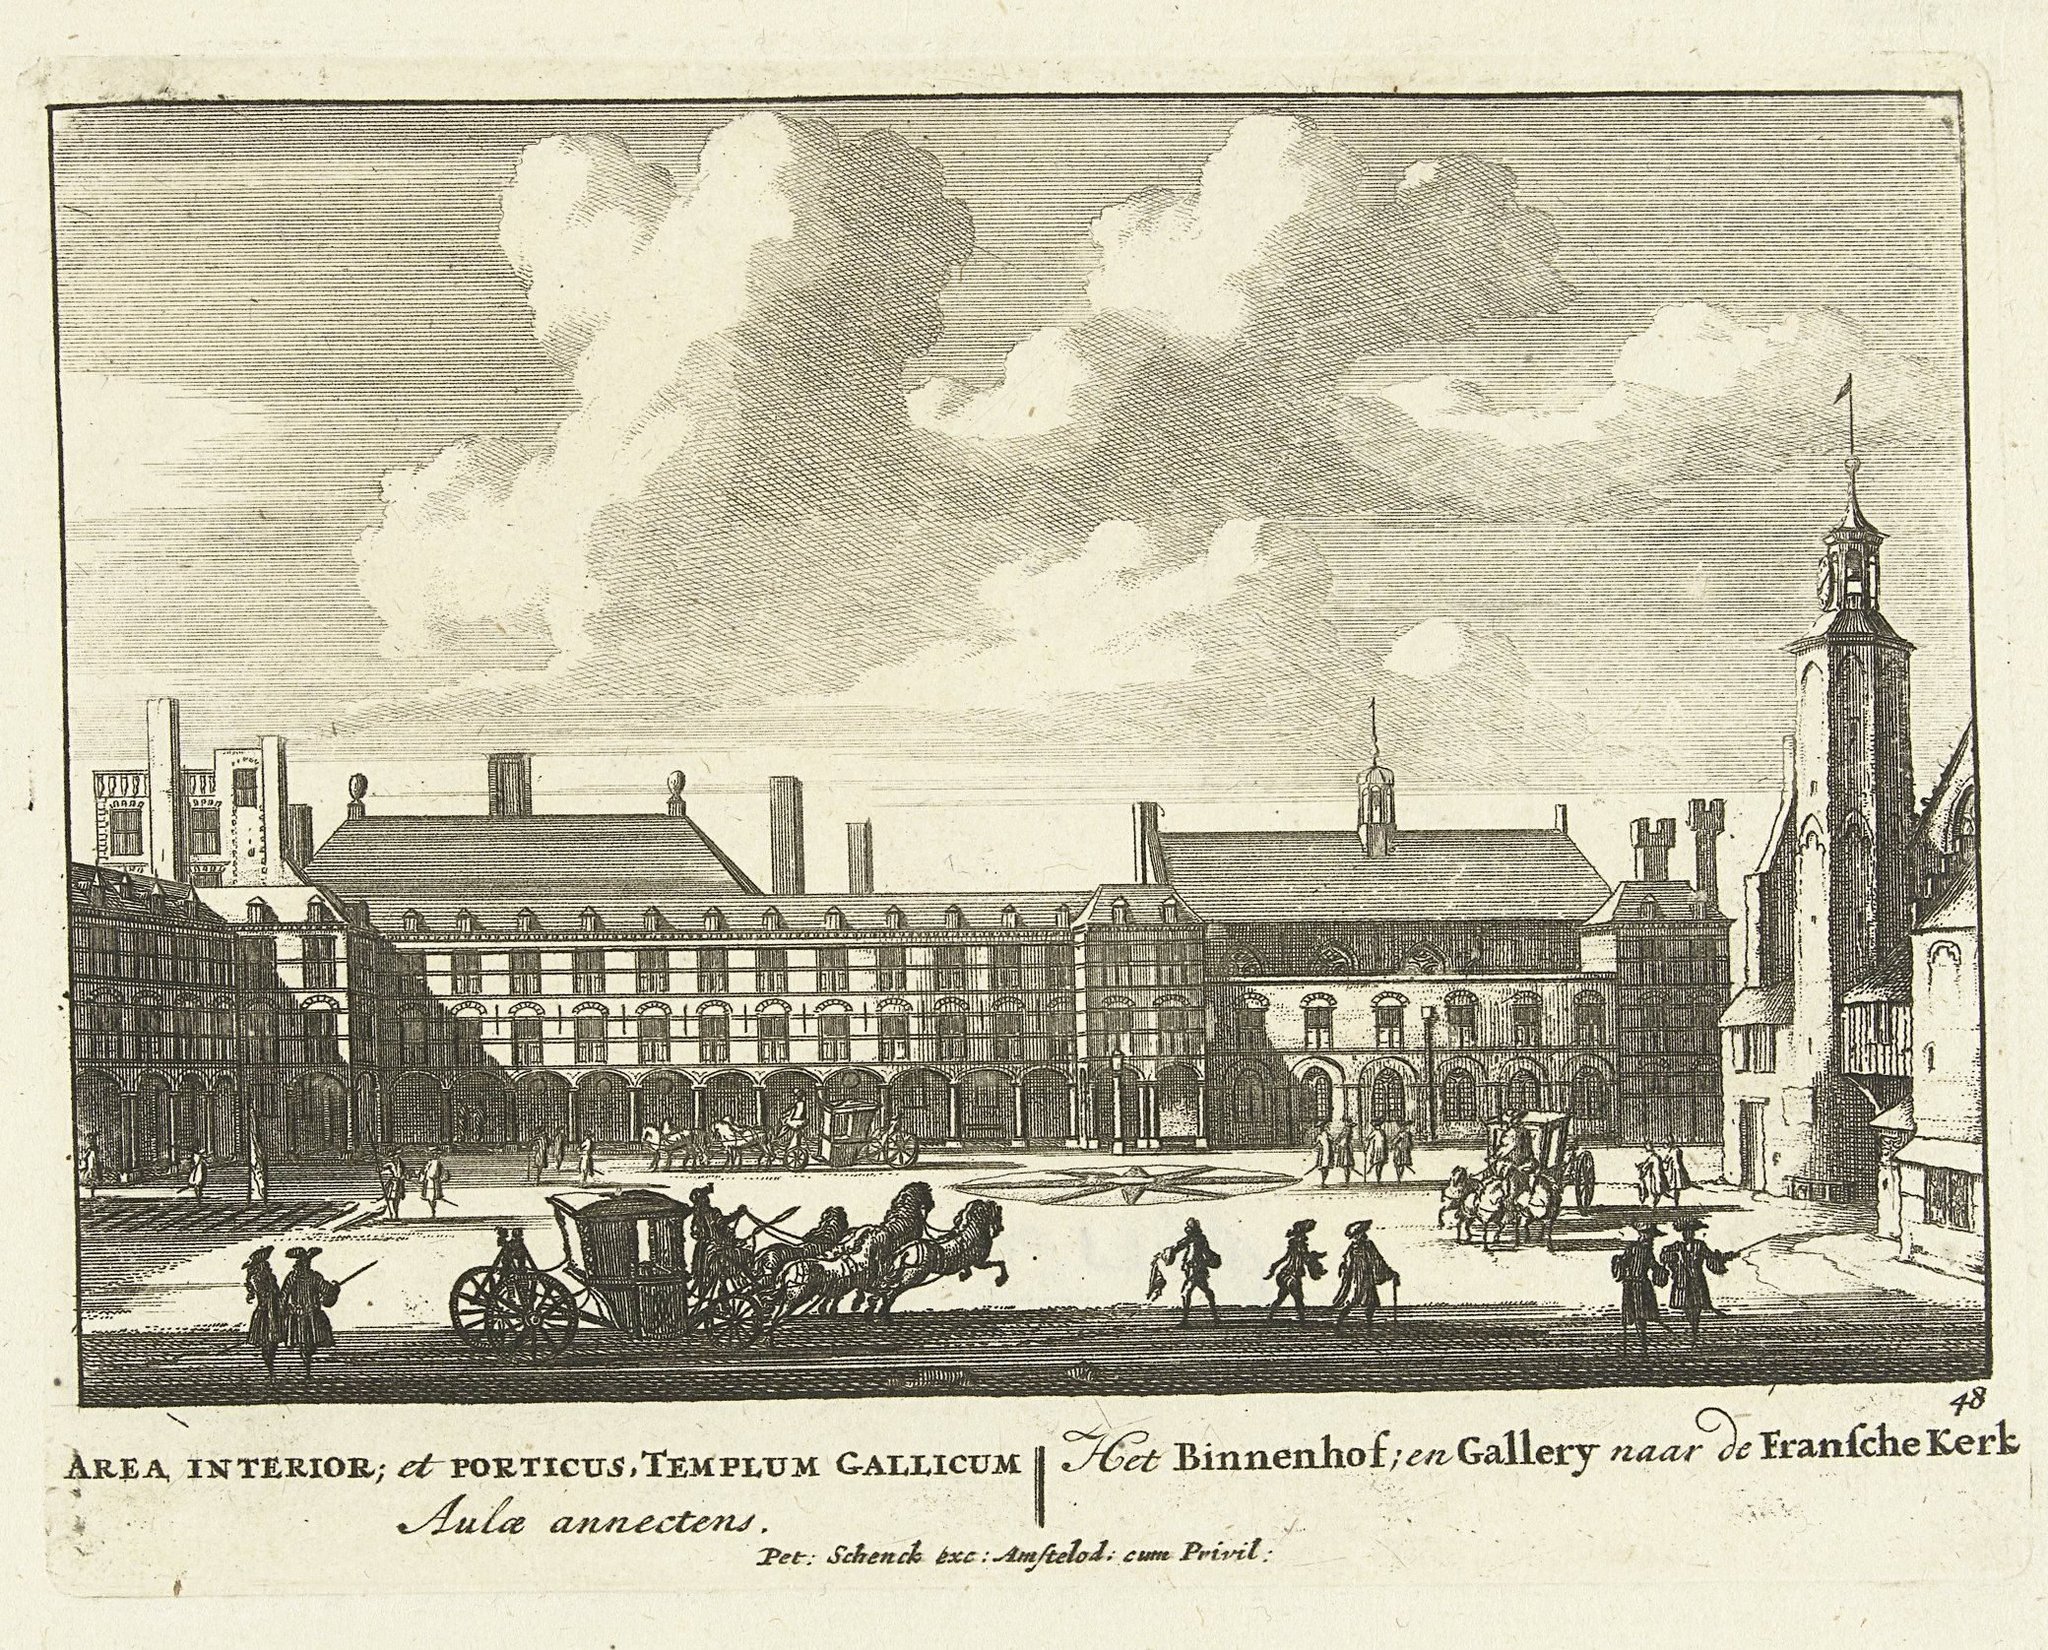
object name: print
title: Vermakelijke Gesigten van het overschone 's-Gravenhage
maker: pieter schenk (i)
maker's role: print maker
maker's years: 1660-1711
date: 1695-1705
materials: paper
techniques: etching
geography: amsterdam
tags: village square, place, the hague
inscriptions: collector's mark: Lugt 2228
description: Prent uit een serie van 71 prenten met Rijnlandschappen, gezichten op vorstelijke paleizen en stadsgezichten uit Den Haag en Amsterdam.